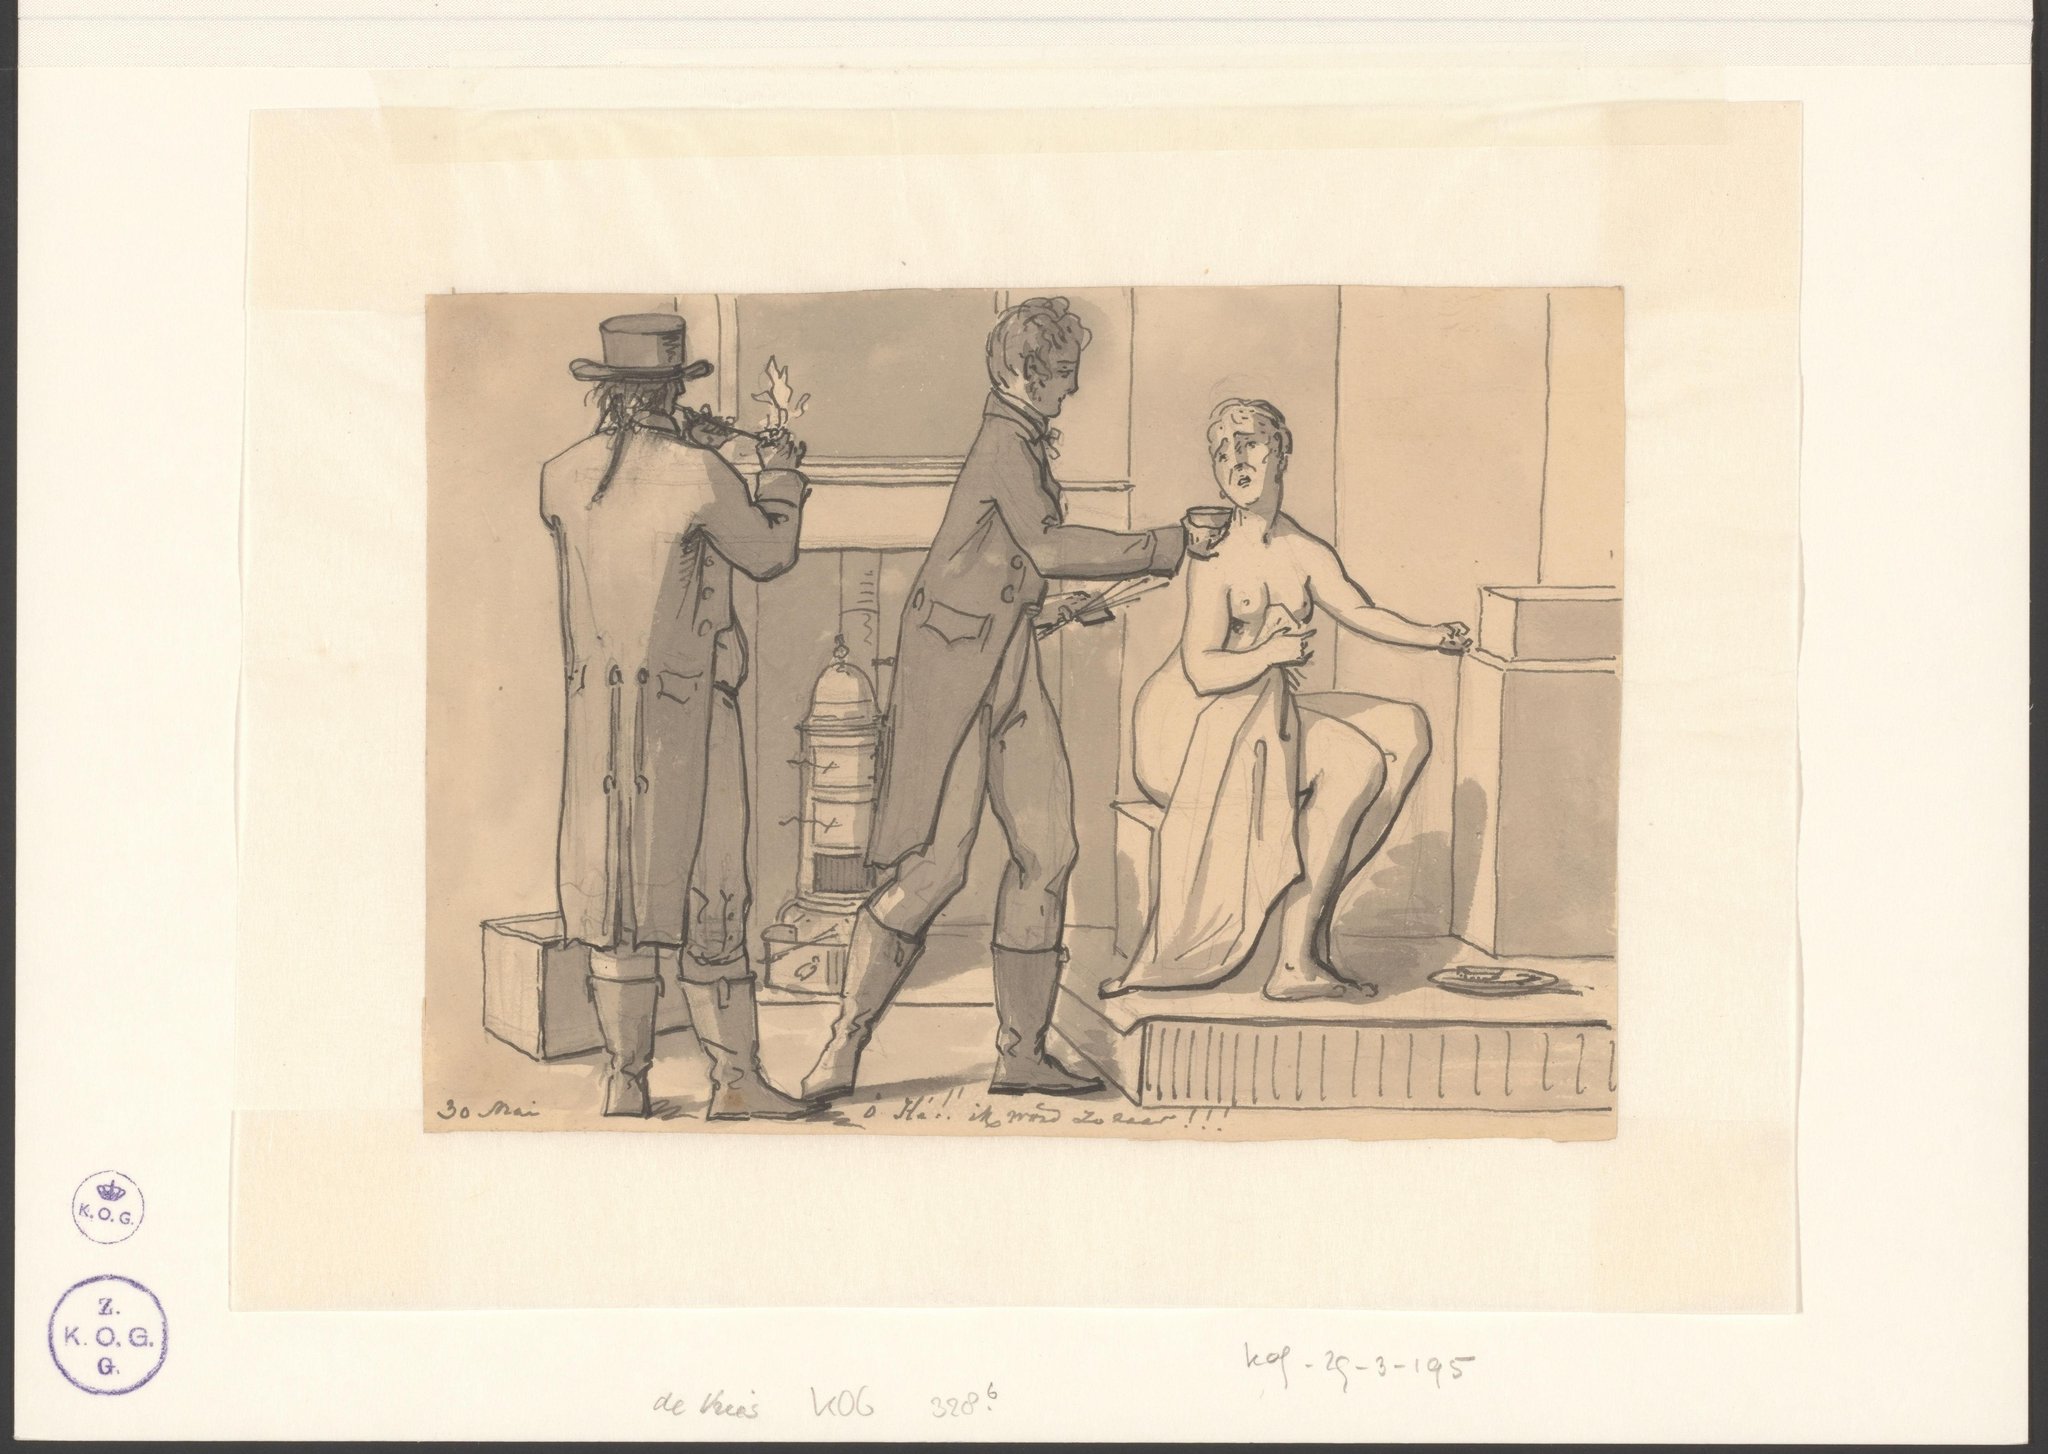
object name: drawing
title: Naaktmodel wordt niet lekker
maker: christiaan andriessen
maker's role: draughtsman, print maker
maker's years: 1775-1846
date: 1805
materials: ink, paper, pencil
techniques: brush, pen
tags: amsterdam, print maker, draughtsman, christiaan andriessen, painter working from live model, patient, sick person, working situations ~ painter, painter working from nude model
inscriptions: collector's mark: Lugt 1641a, inscription: ‘30 mai o Hé!! ik word zo raar!!!’, signature: ‘J Andriessen’, collector's mark: Lugt 1641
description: Naaktmodel geeft aan dat ze zich niet goed voelt. Christiaan Andriessen reikt haar iets te drinken aan.